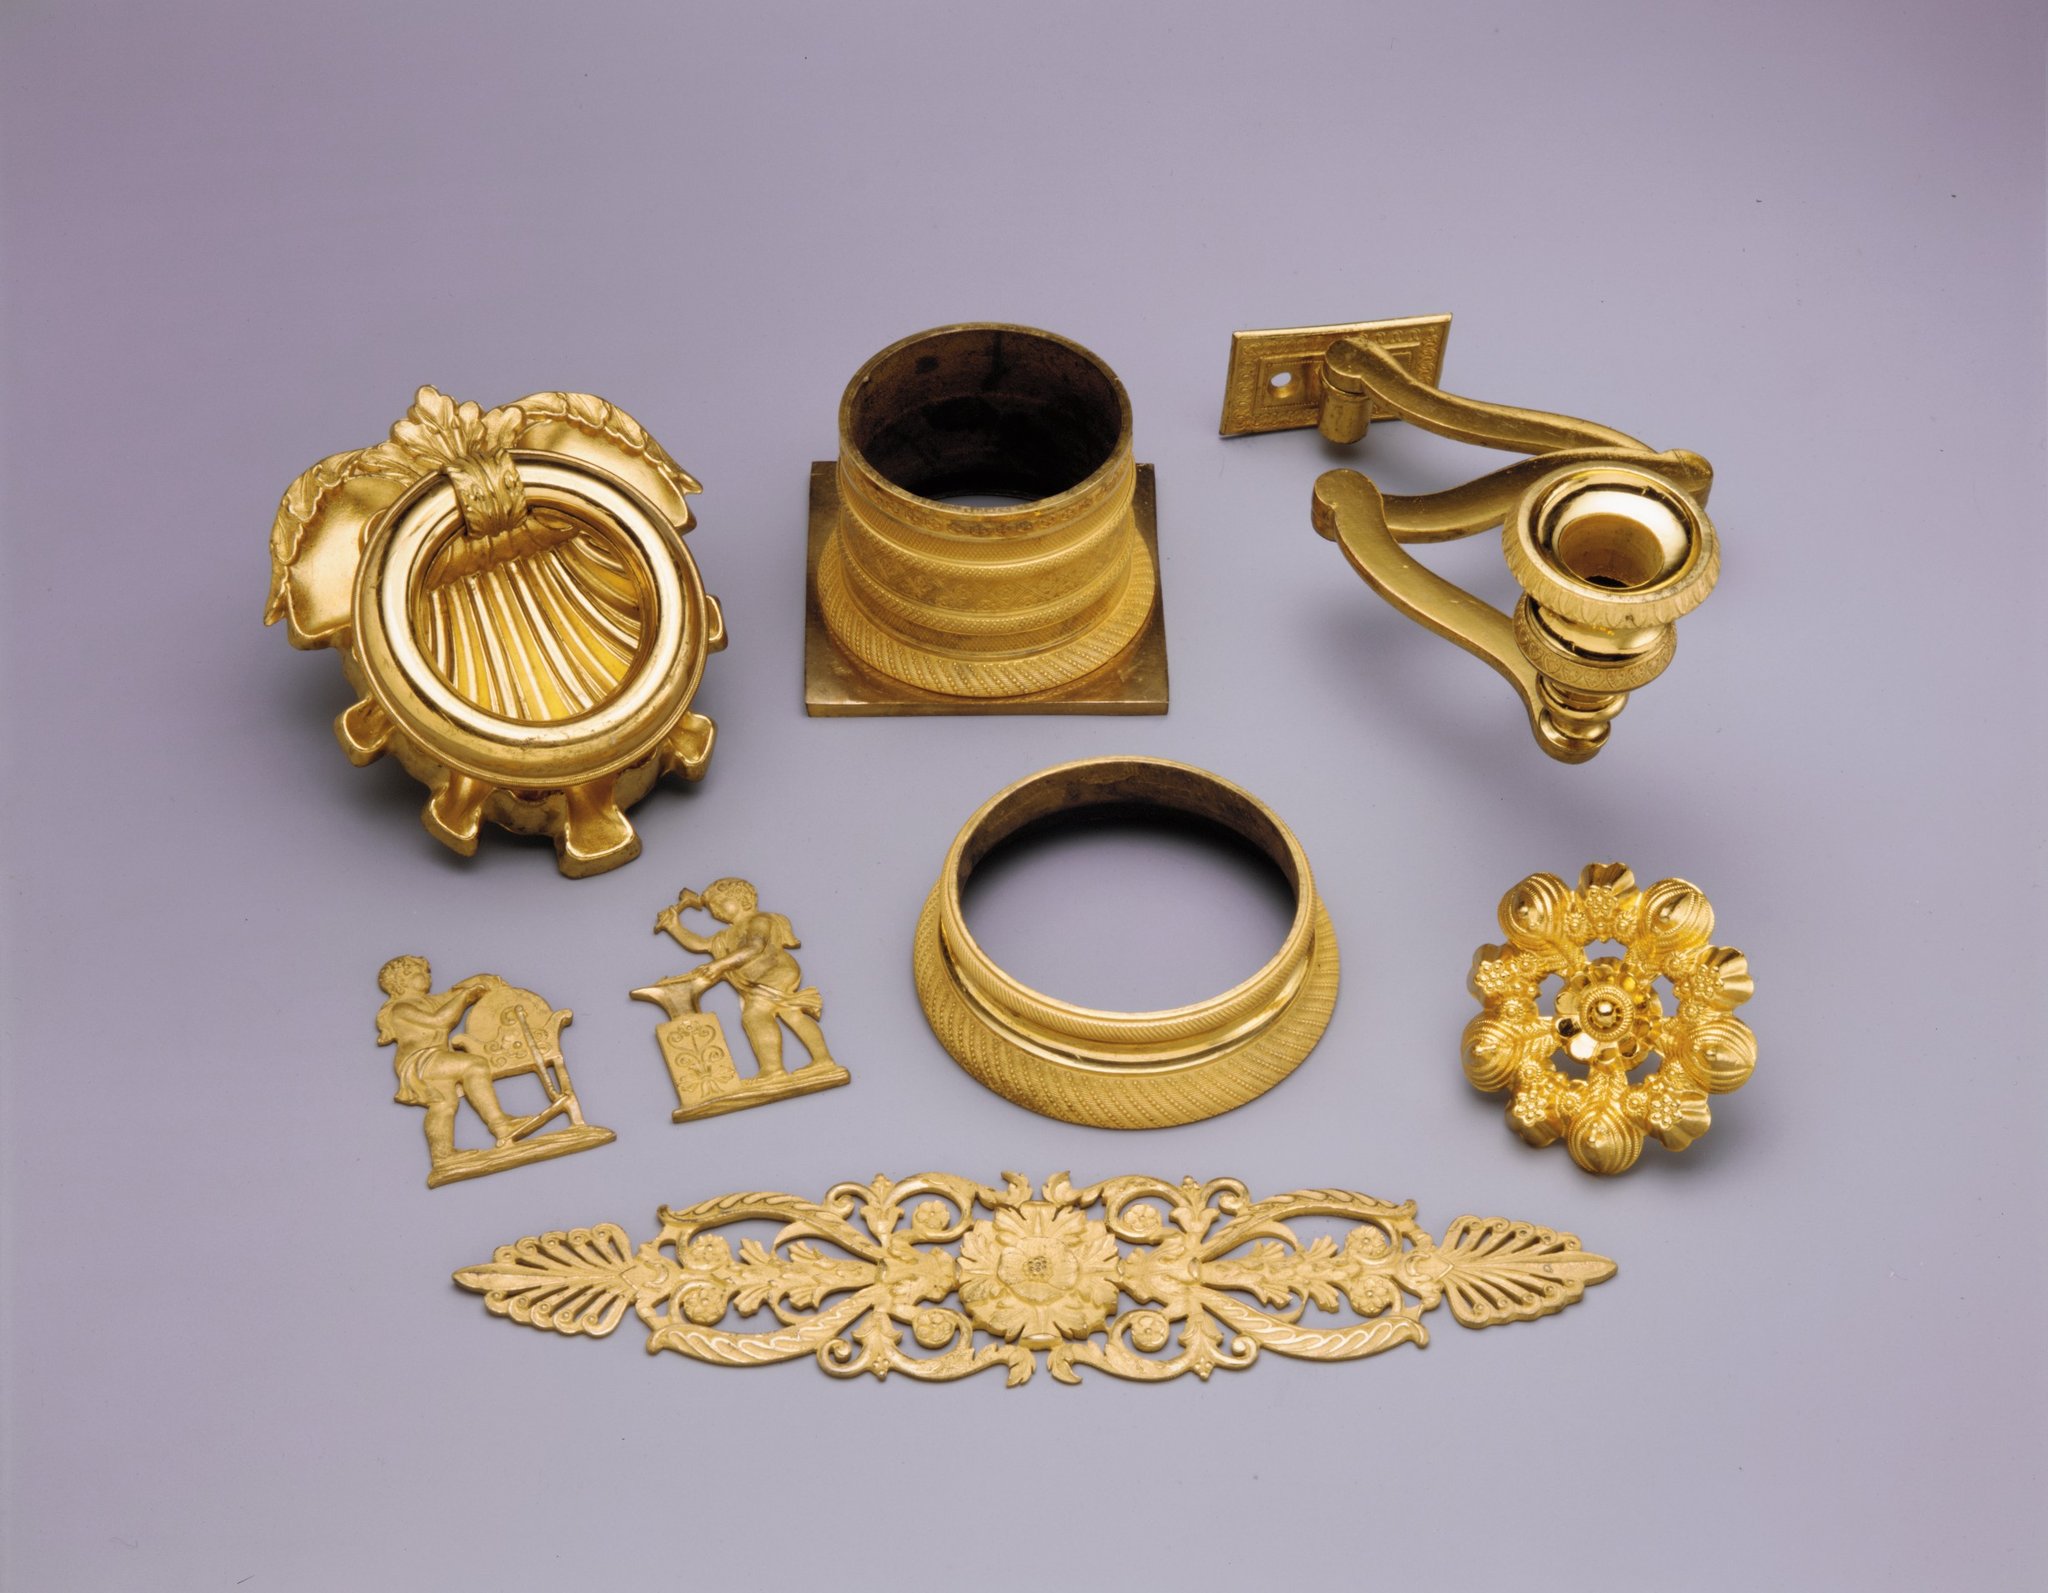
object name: furniture hardware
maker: henry kellam hancock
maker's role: retailer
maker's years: 1816-1851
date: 1820-1830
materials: brass, gilt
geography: france